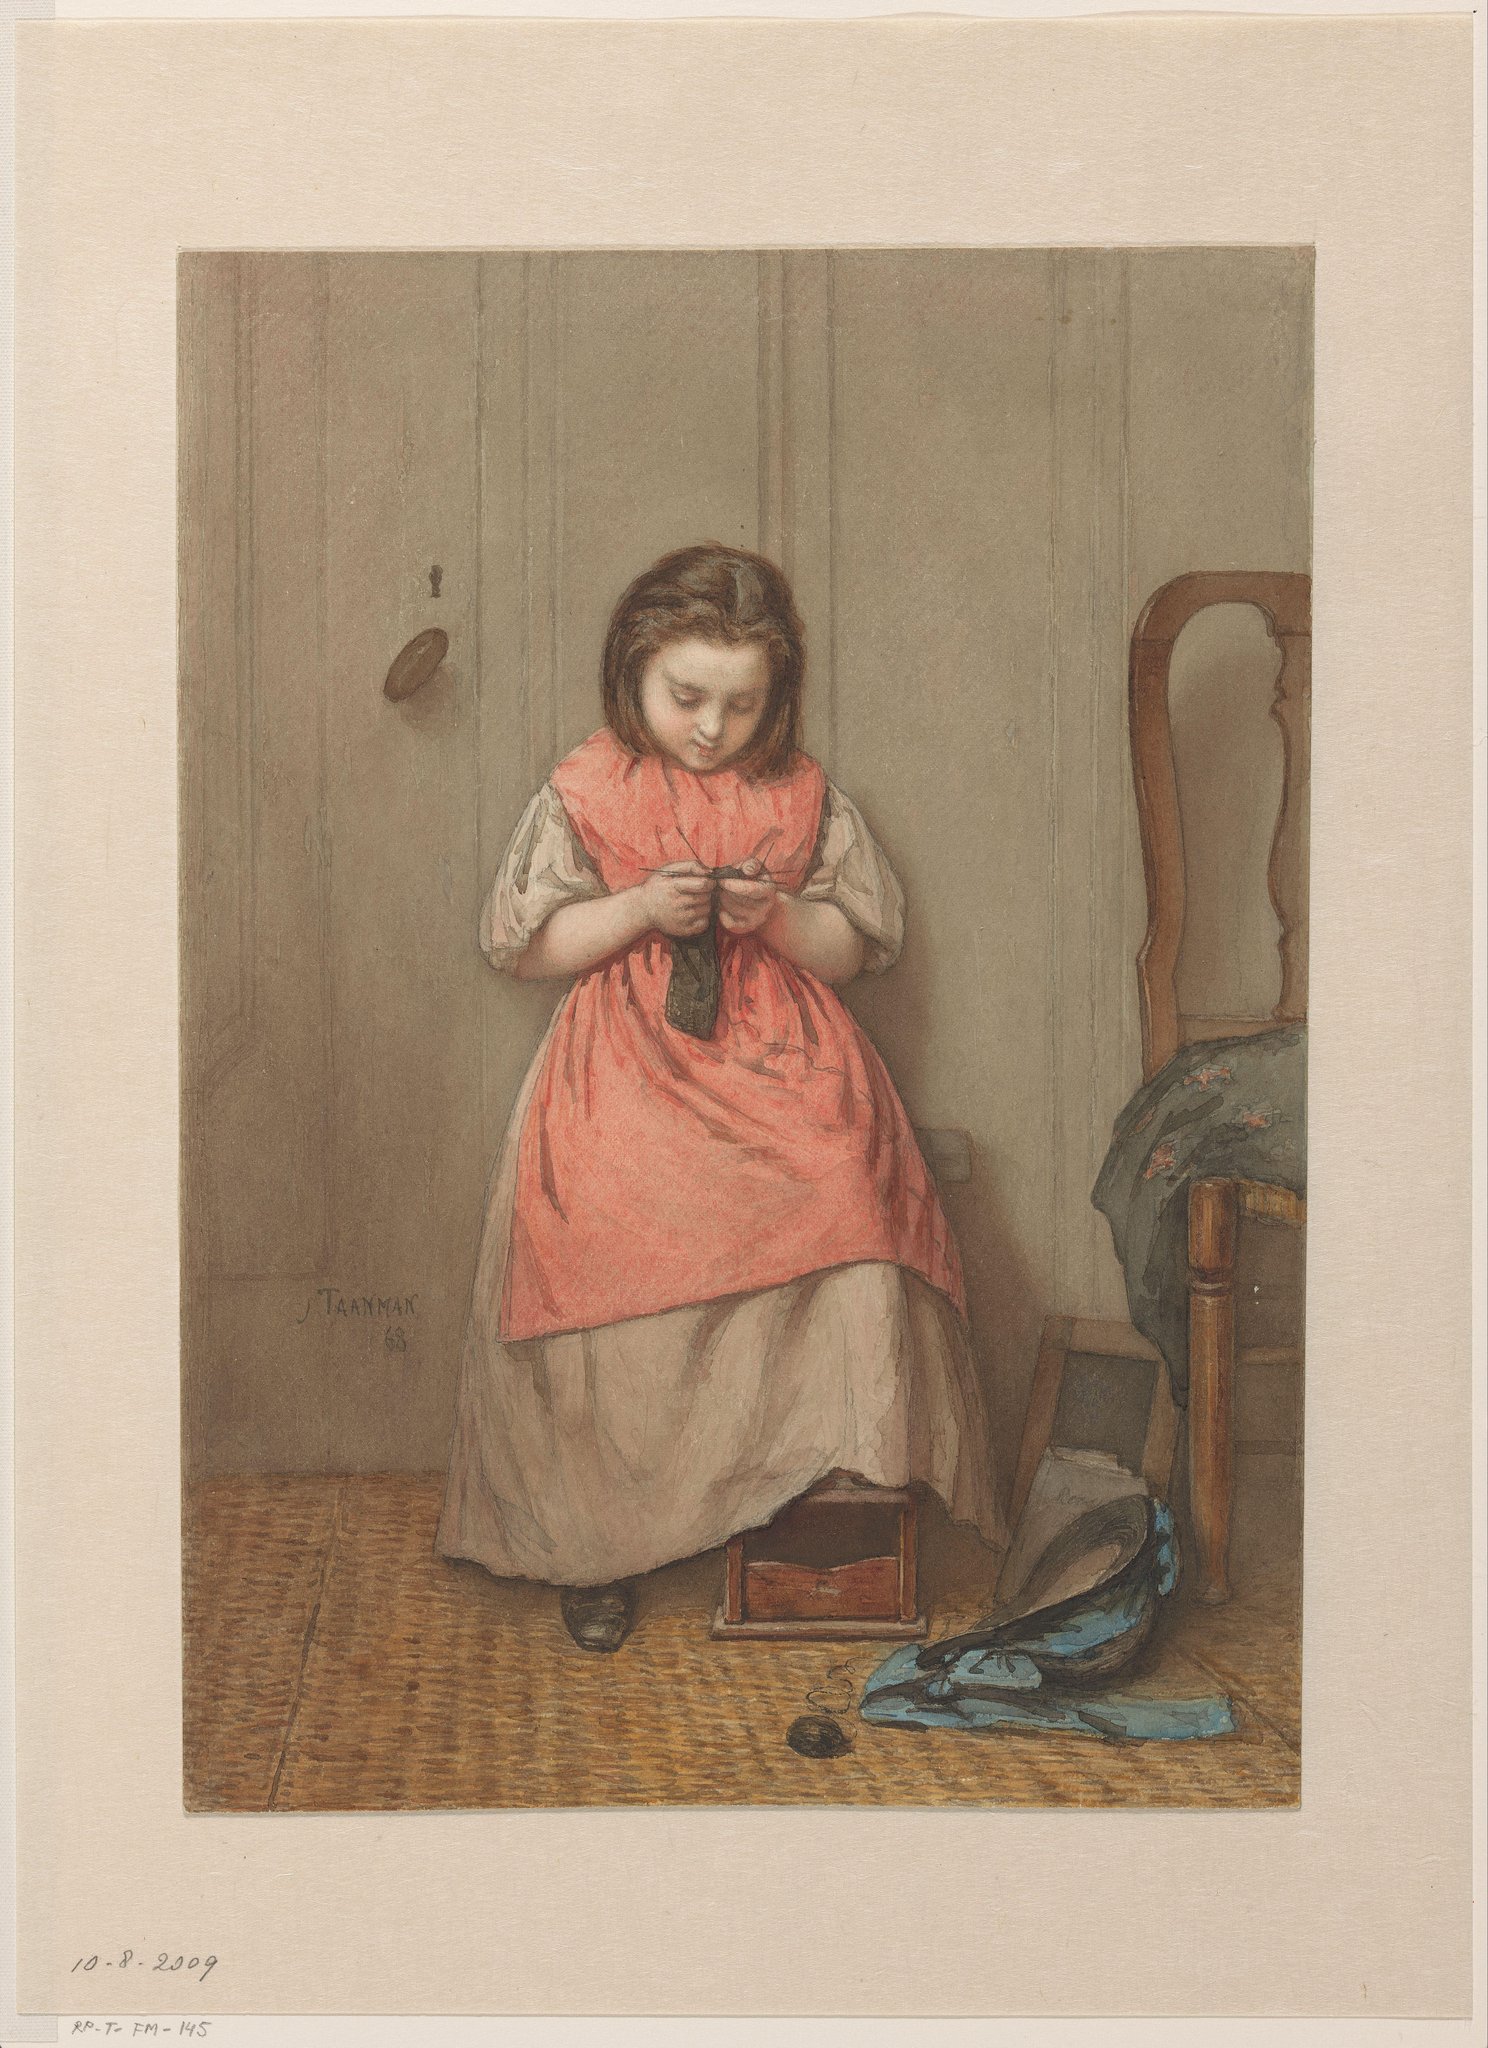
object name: watercolor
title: Interieur met breiend meisje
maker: jacob taanman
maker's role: draughtsman, print maker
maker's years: 1836-1923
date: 1868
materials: chalk, paper, watercolor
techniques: brush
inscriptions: date: ‘68’